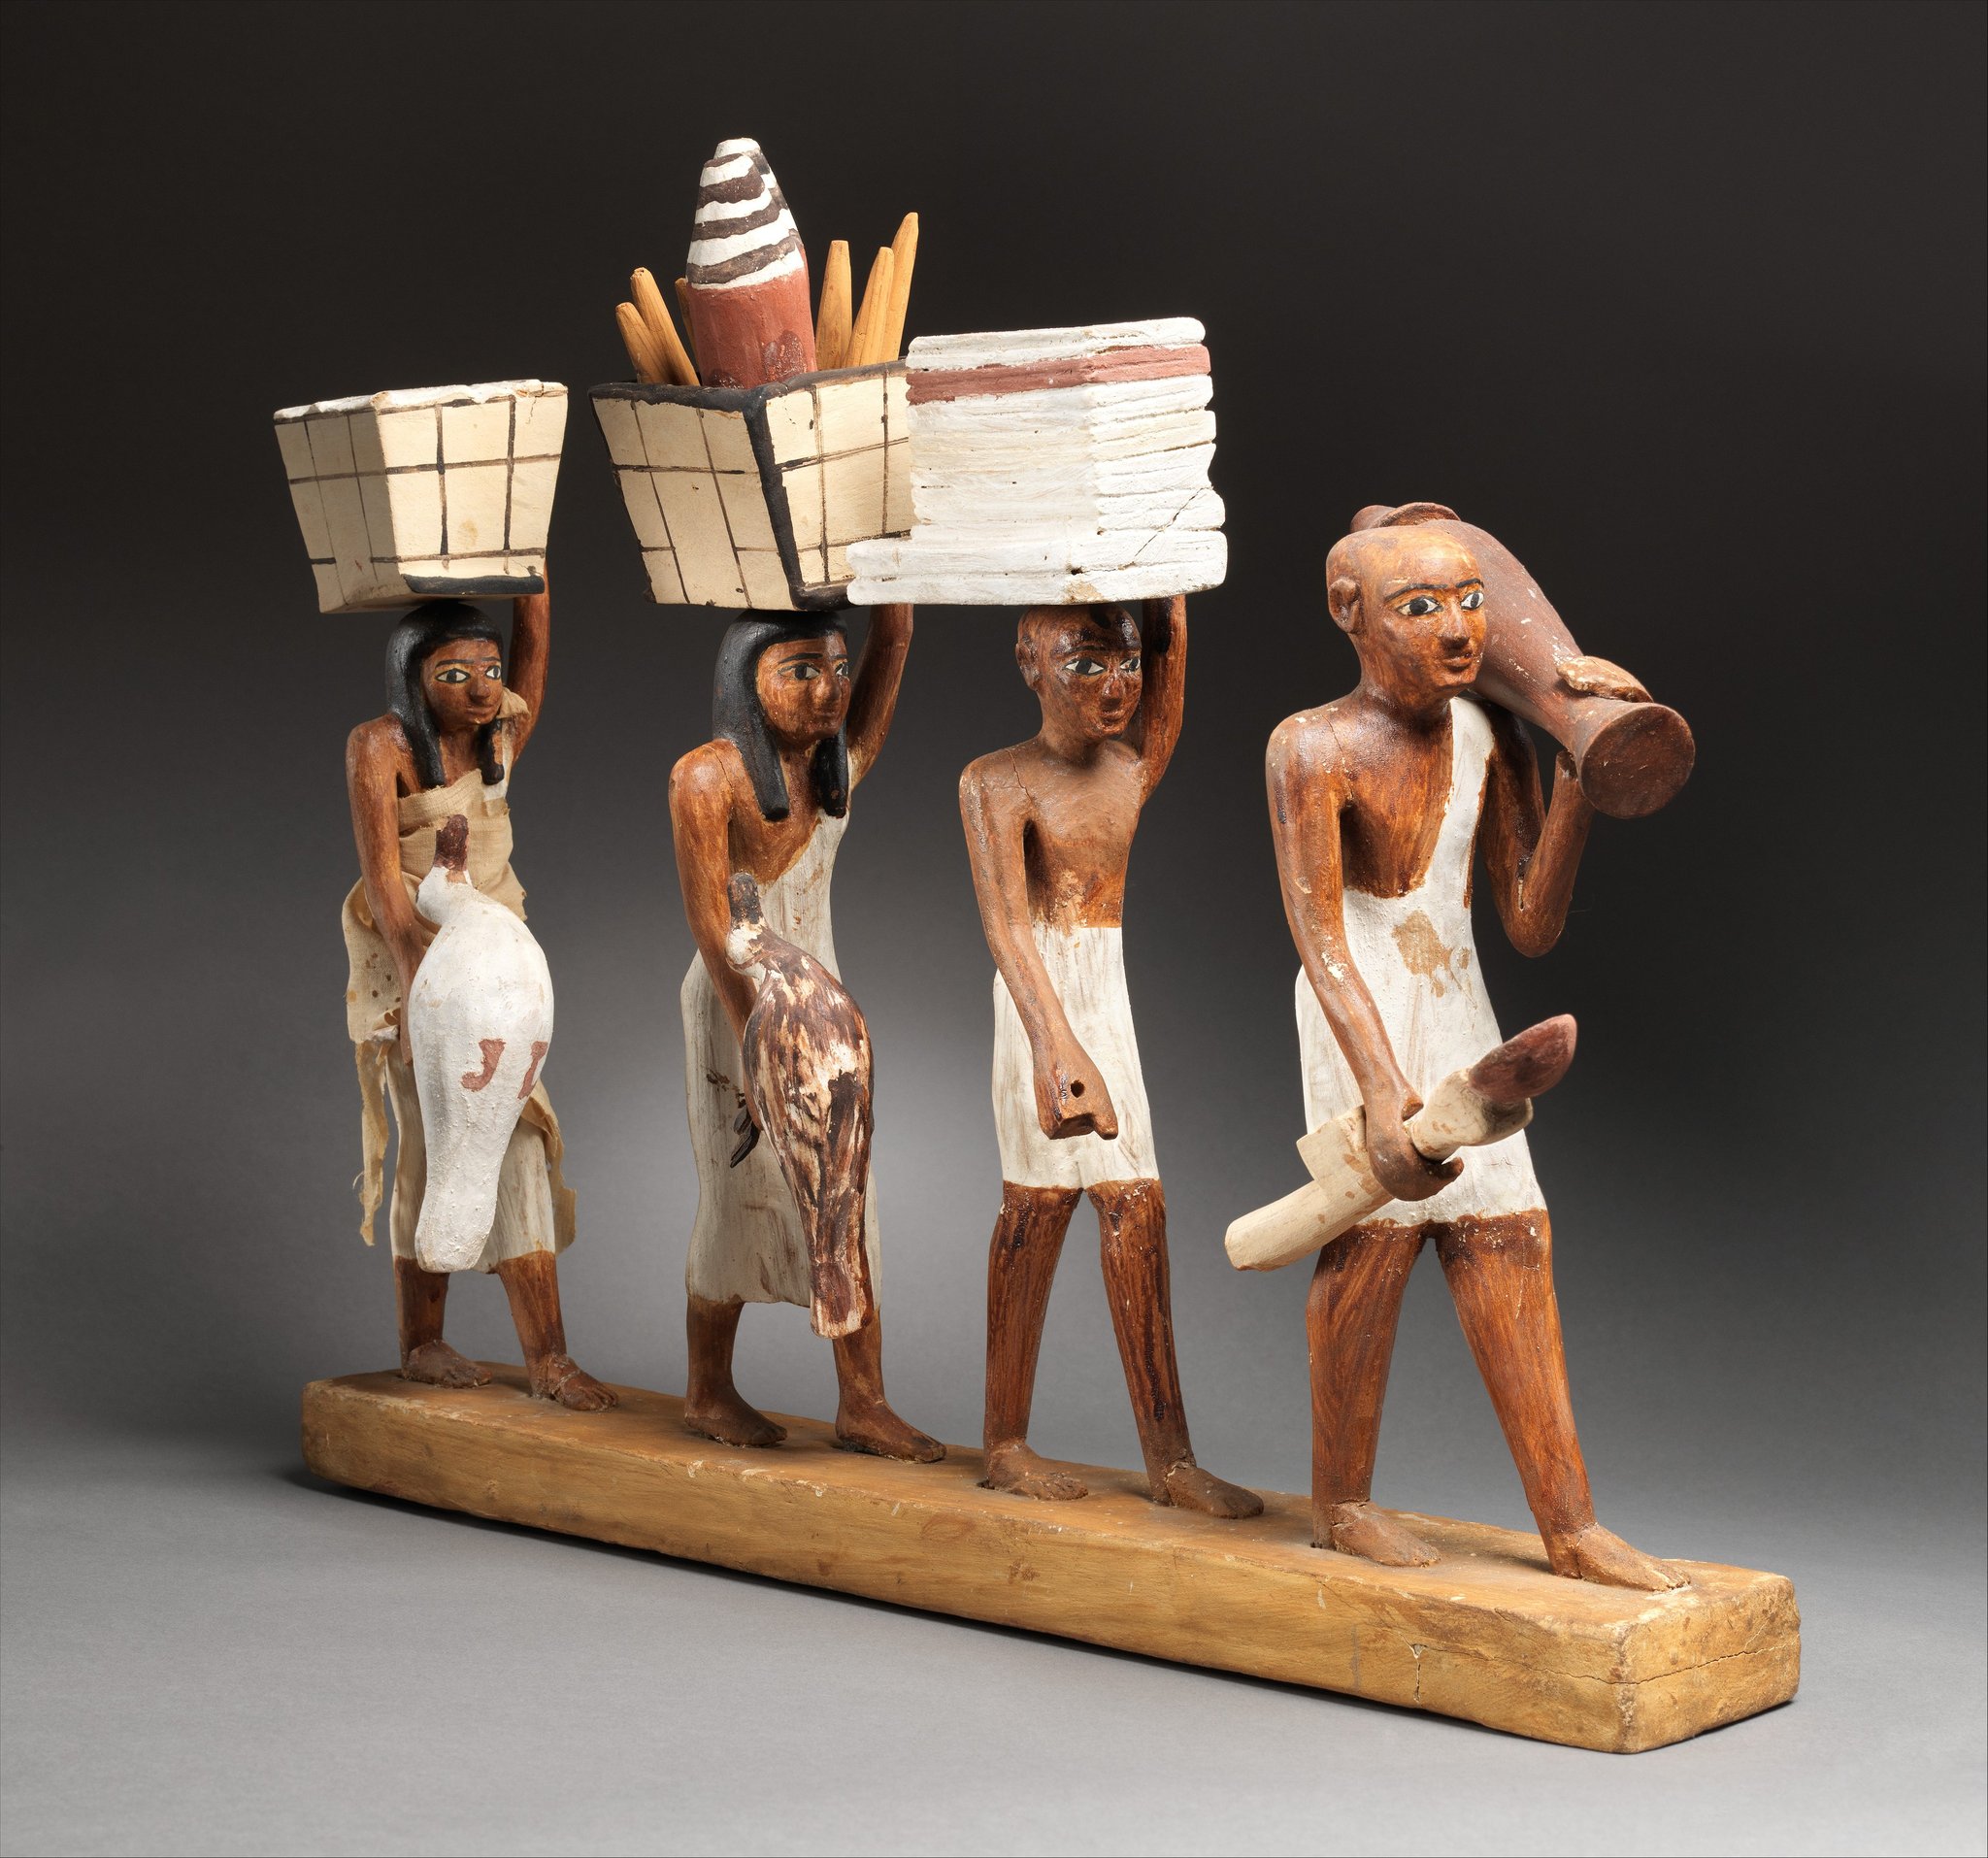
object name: model, offering, procession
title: Model of a procession of offering bearers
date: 1981-1975 BCE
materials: linen, wood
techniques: painting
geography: egypt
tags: men,women,walking,meketre-models